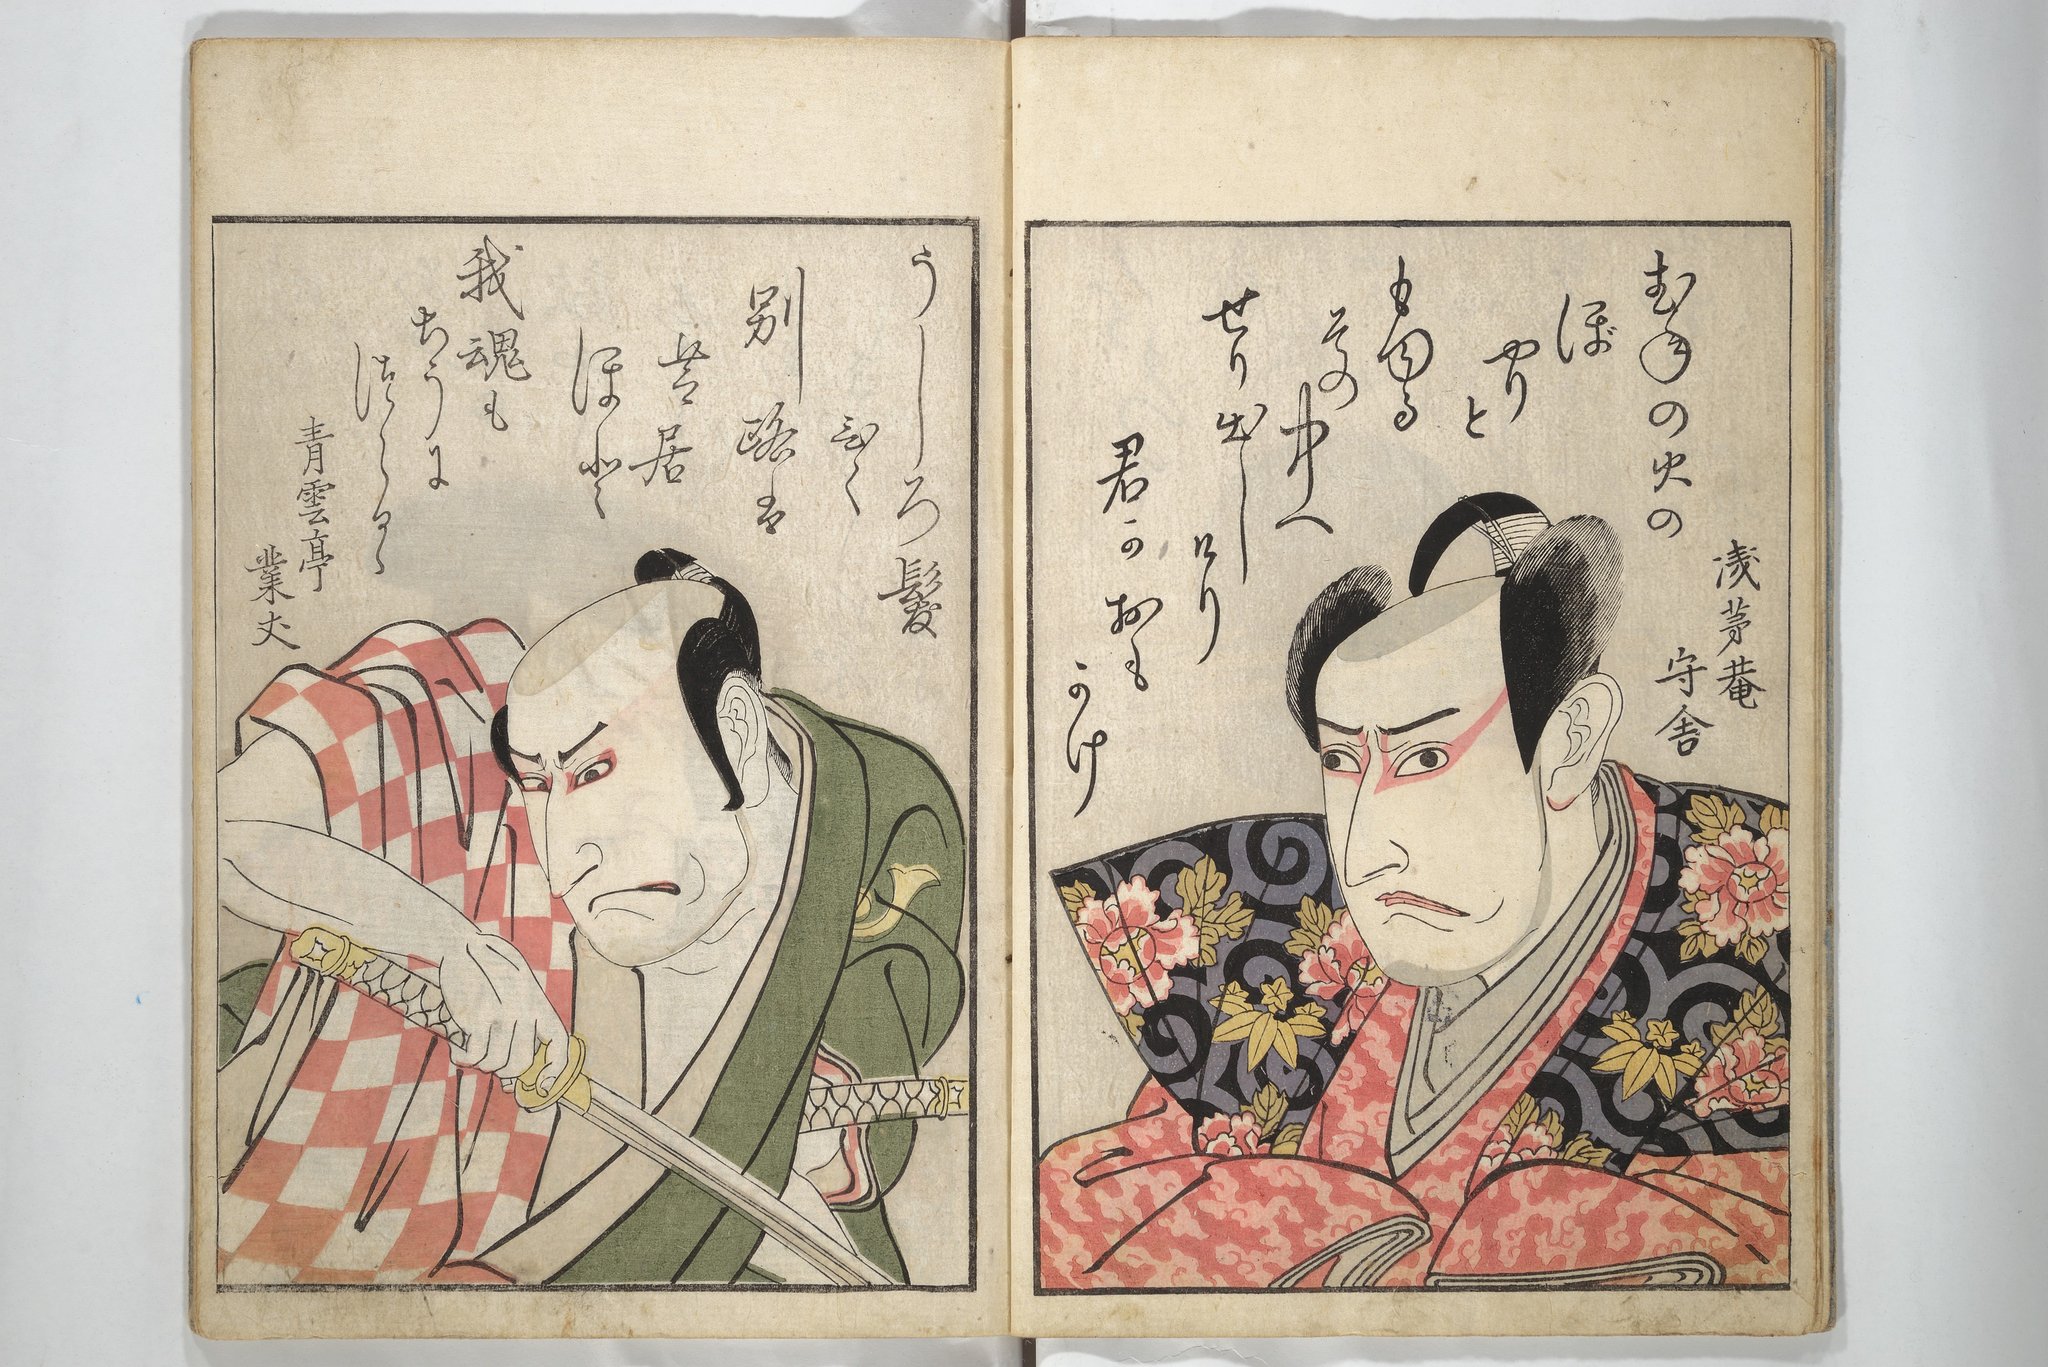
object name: illustrated book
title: Mirror Images of Kabuki Actors (Yakusha awase kagami) 俳優相貎鏡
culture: japanese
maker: utagawa toyokuni i 歌川豊国一世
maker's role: artist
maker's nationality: japanese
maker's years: 1769-1825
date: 1804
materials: ink, paper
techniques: woodblock print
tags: men,portraits,actors